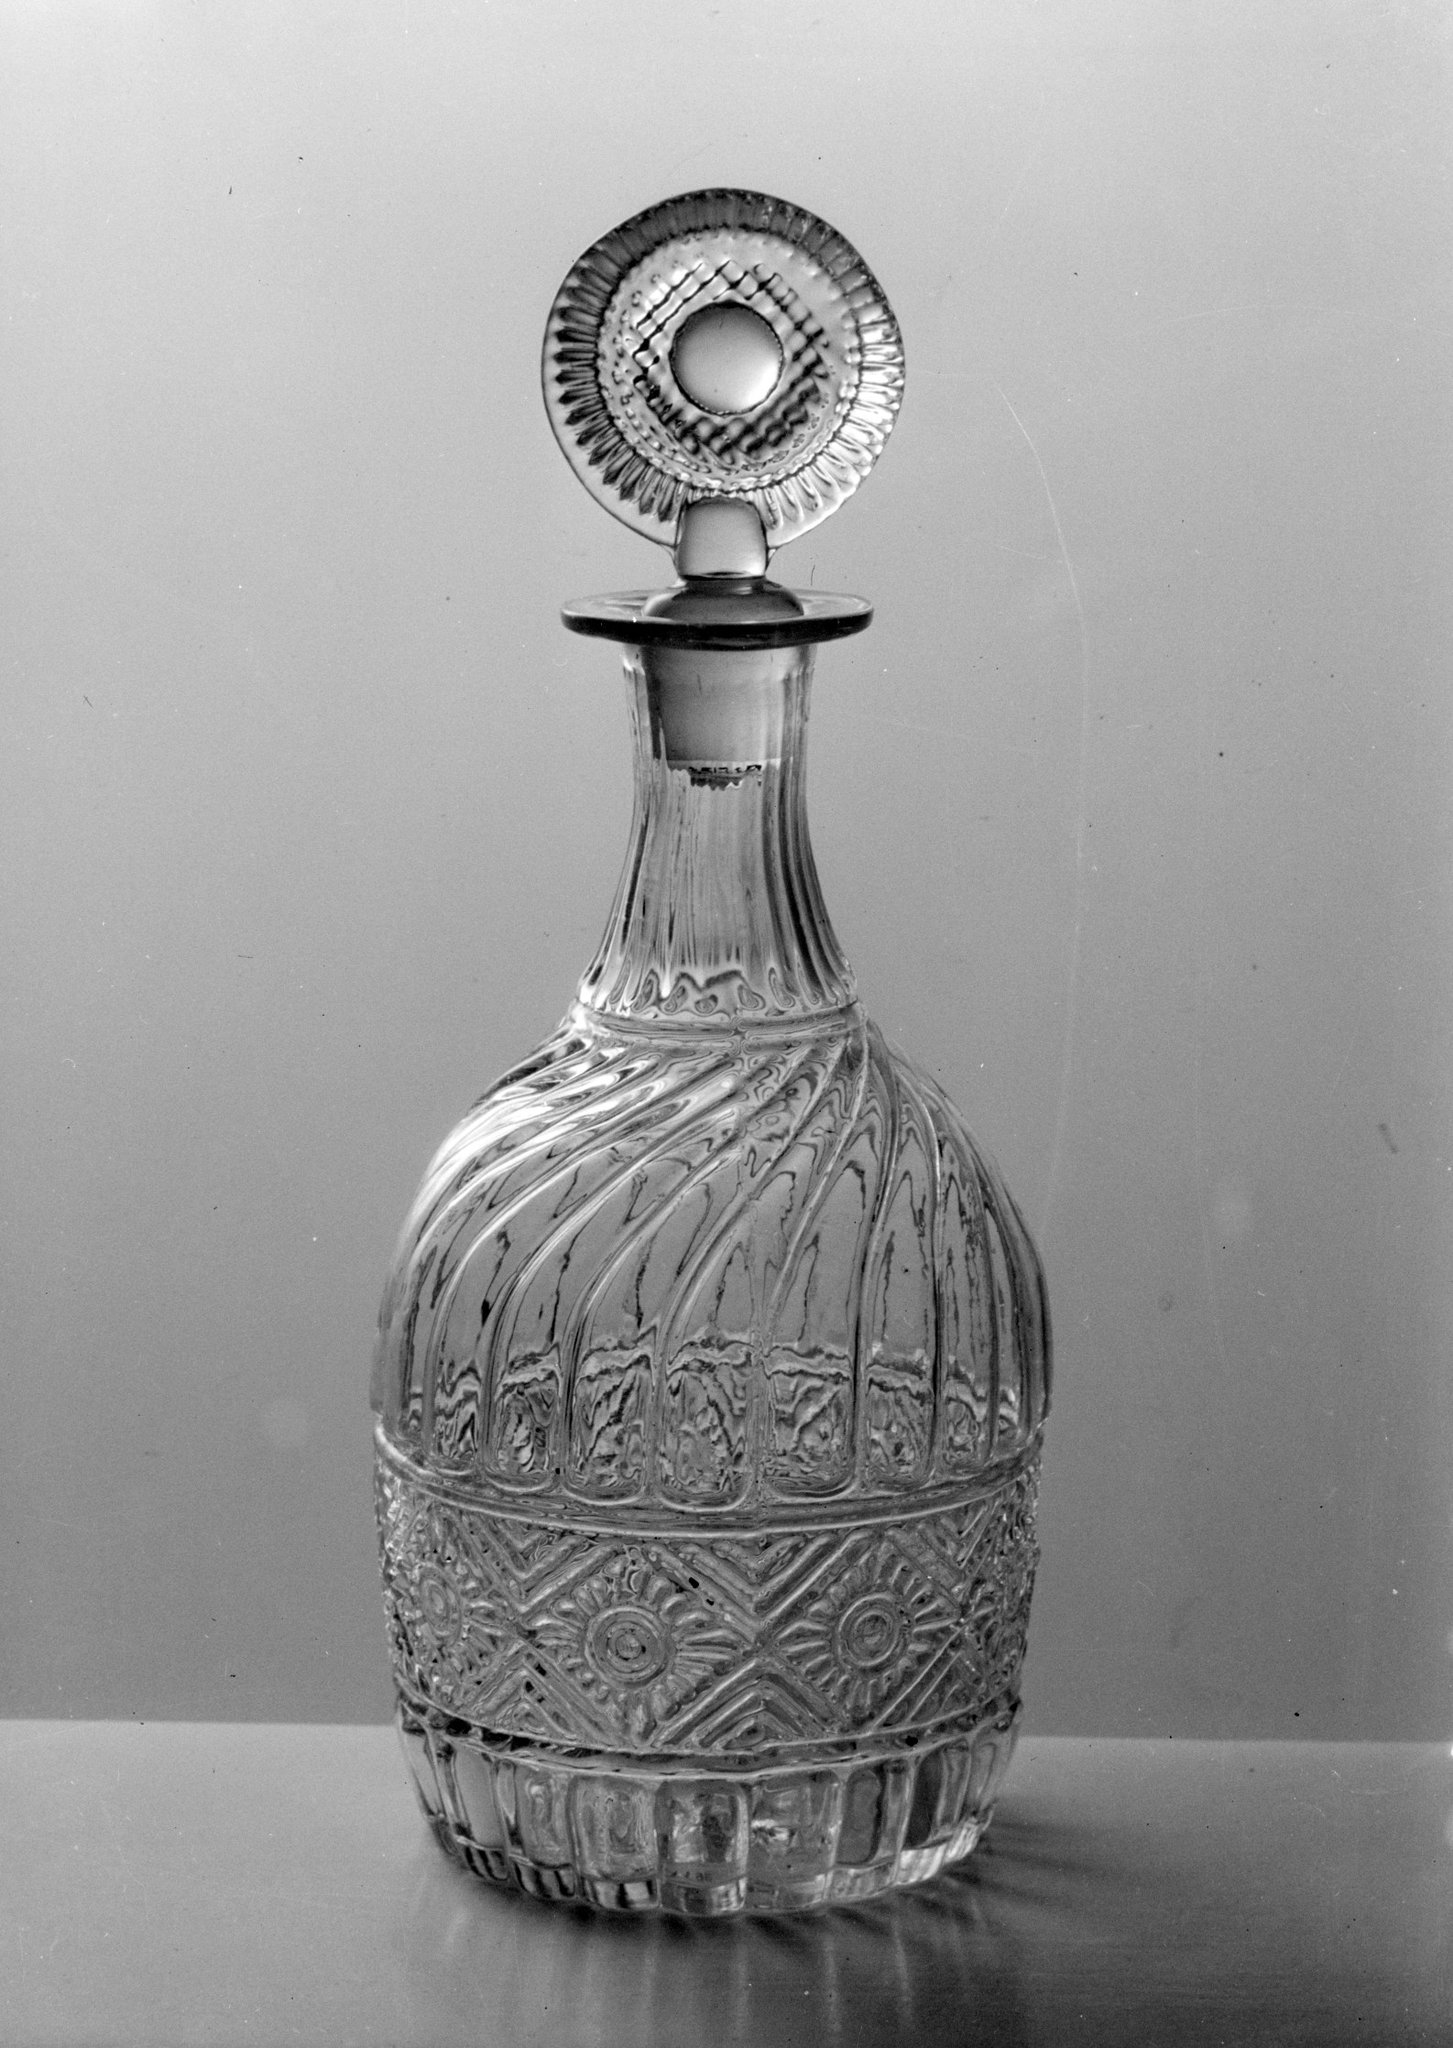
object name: decanter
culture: american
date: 1820-1840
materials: glass, lead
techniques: glassblowing, molding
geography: united states